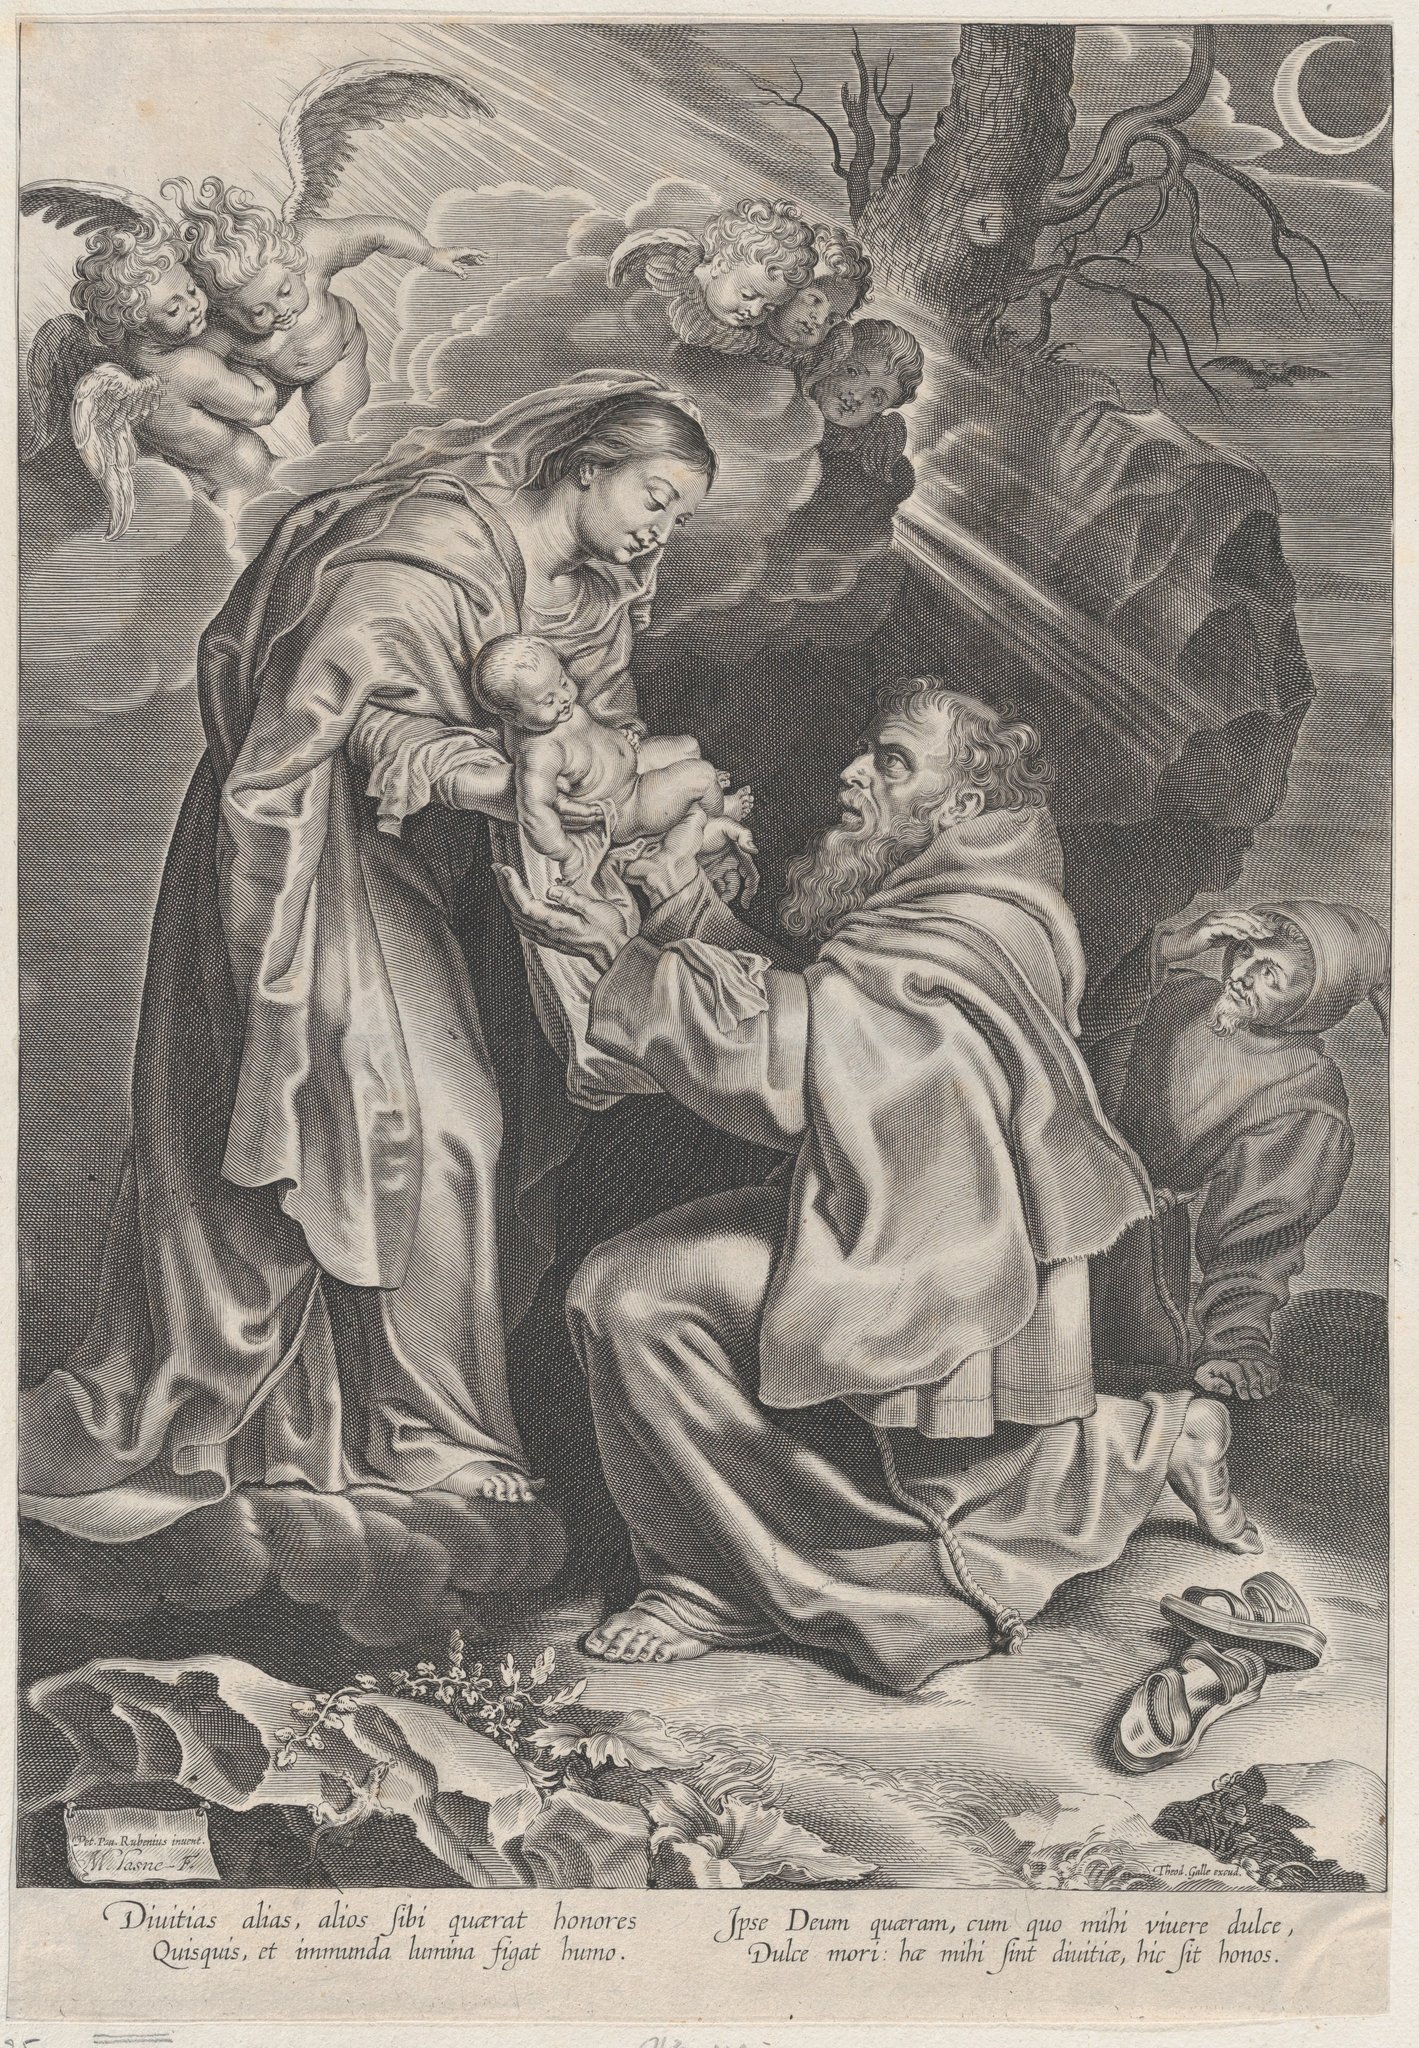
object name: print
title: The Vision of Saint Francis, kneeling at right, receiving the Christ child from the Virgin Mary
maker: michel lasne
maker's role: artist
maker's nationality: french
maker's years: 1590-1667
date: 1617-1620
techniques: engraving, etching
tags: angels,madonna and child,saint francis